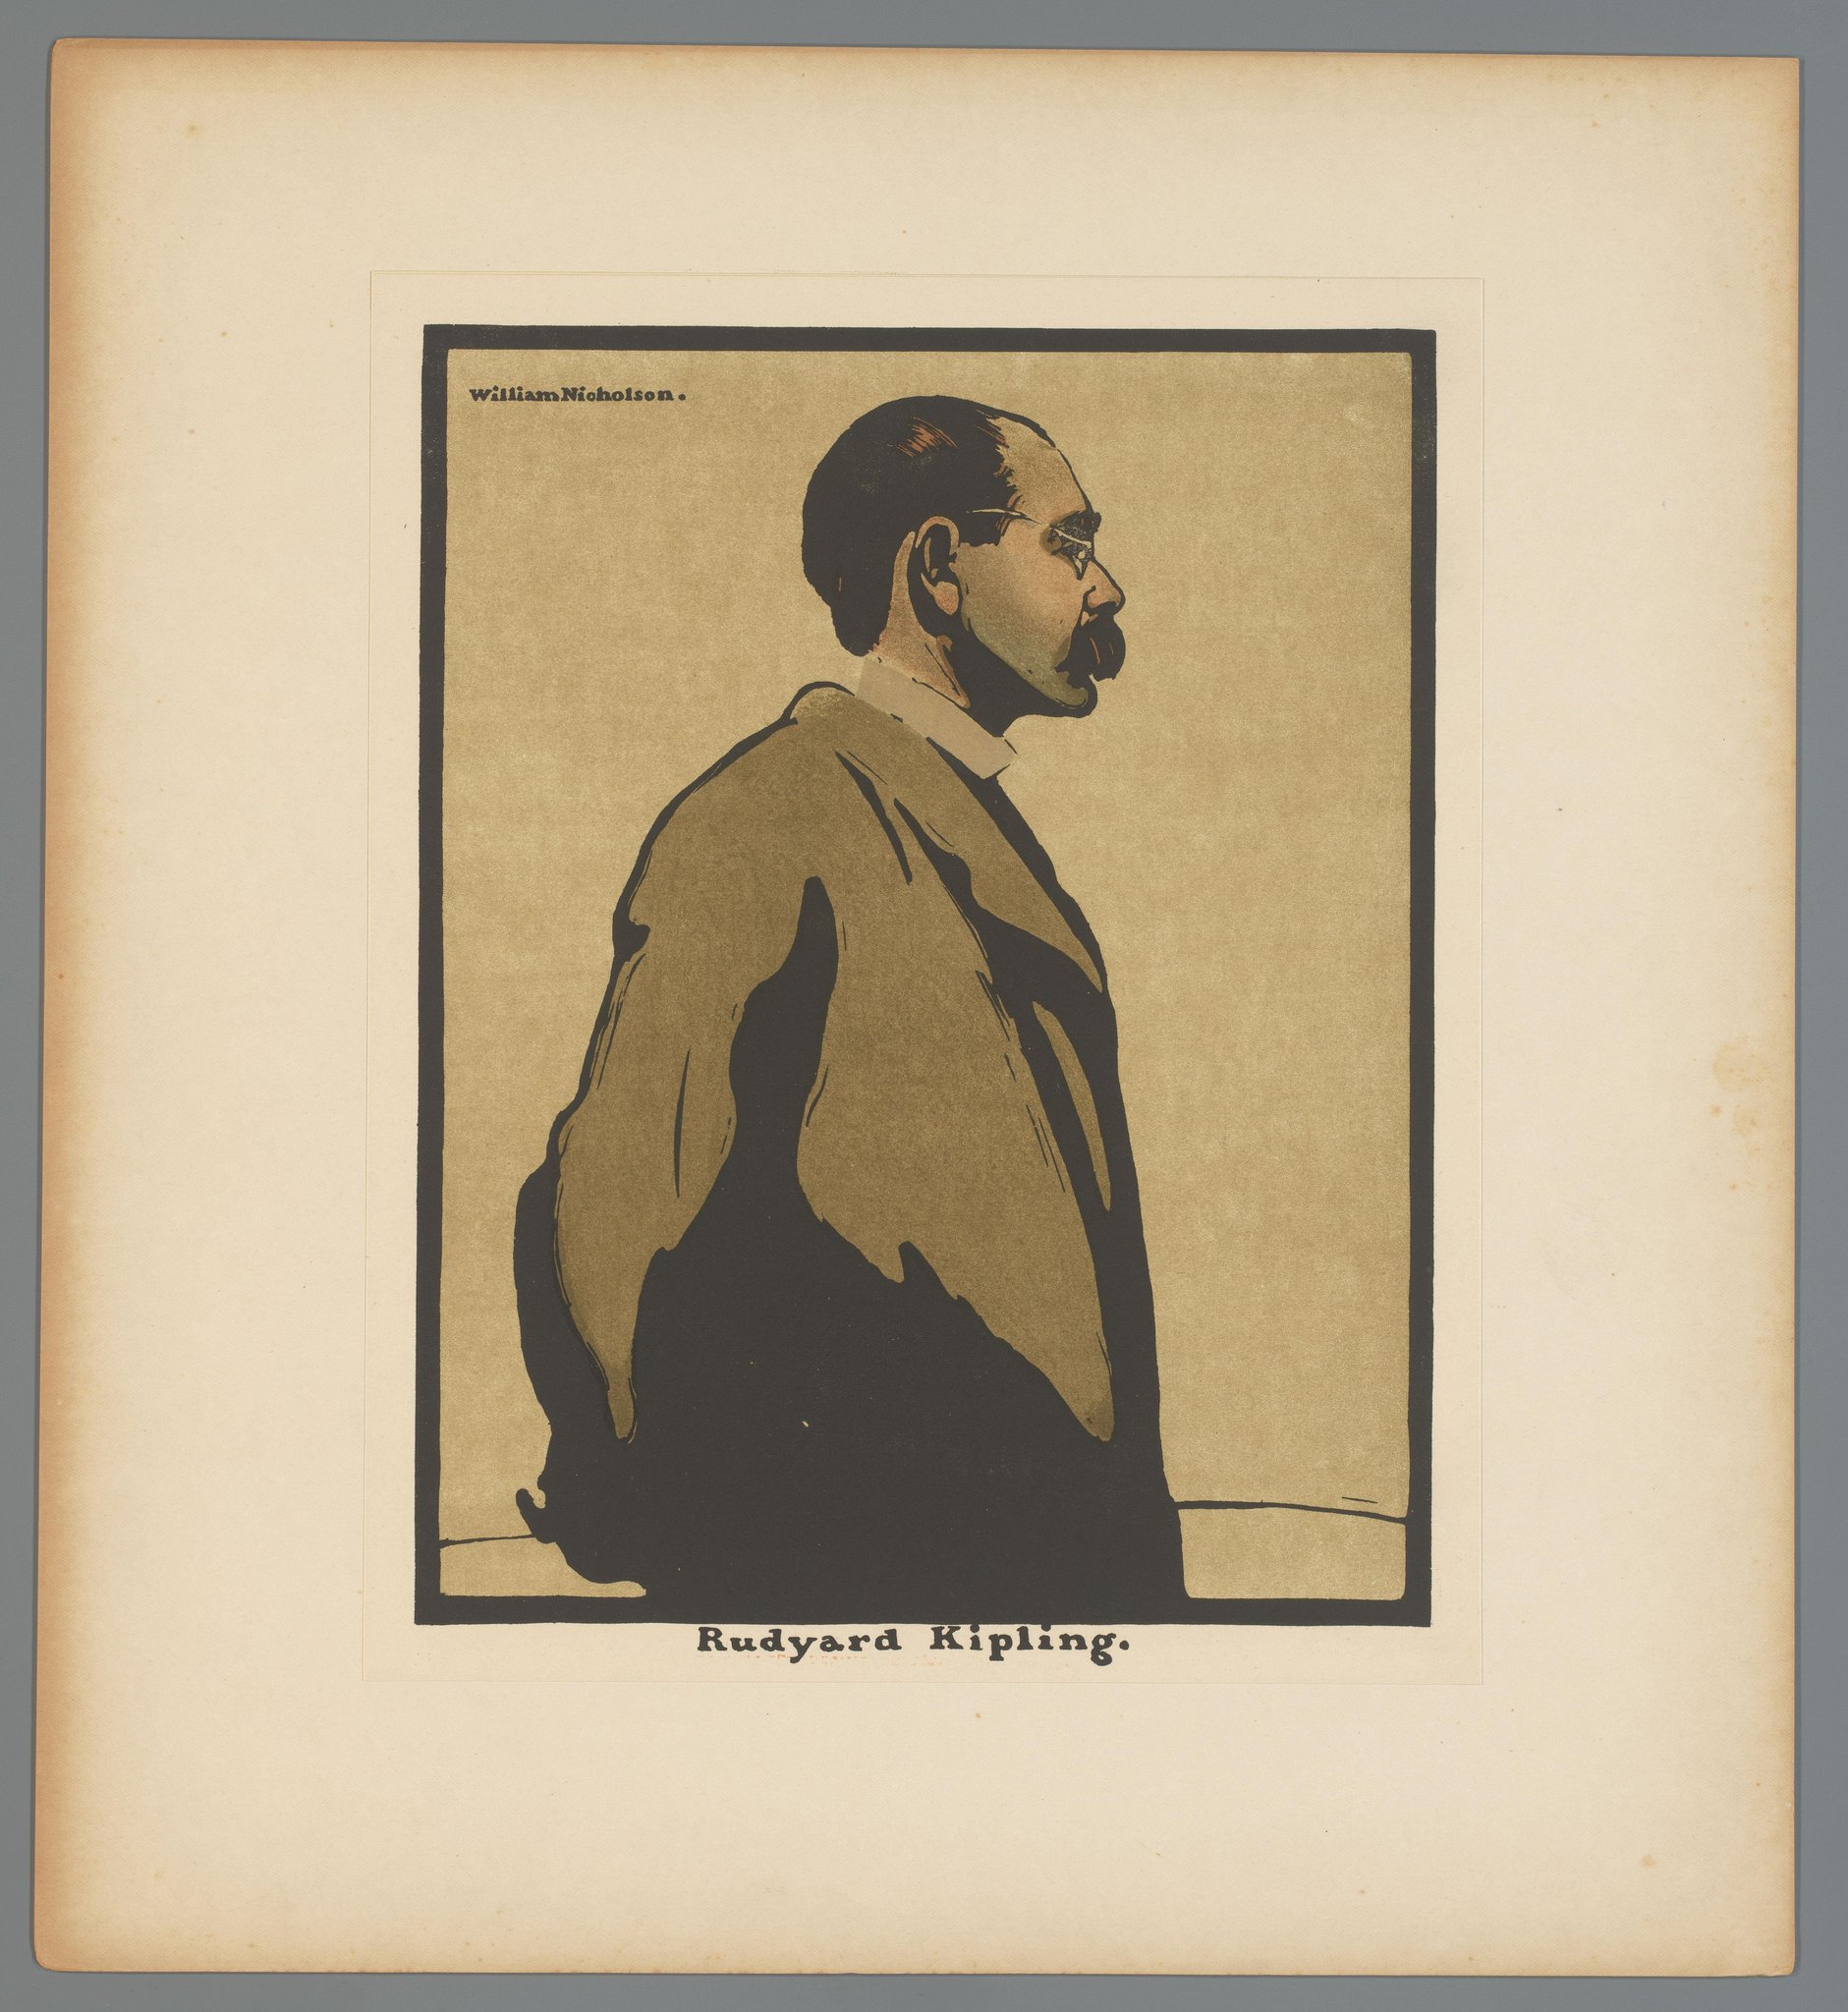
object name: print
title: Douze Portraits par William Nicholson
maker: henri floury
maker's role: publisher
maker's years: 1862-1961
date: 1900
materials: paper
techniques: lithograph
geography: paris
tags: historical persons, writer, poet, author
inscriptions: collector's mark: Lugt 2228, collector's mark: Lugt 2760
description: De serie met lithografieën is gemaakt naar ontwerpen van houtsneden door William Nicholson.